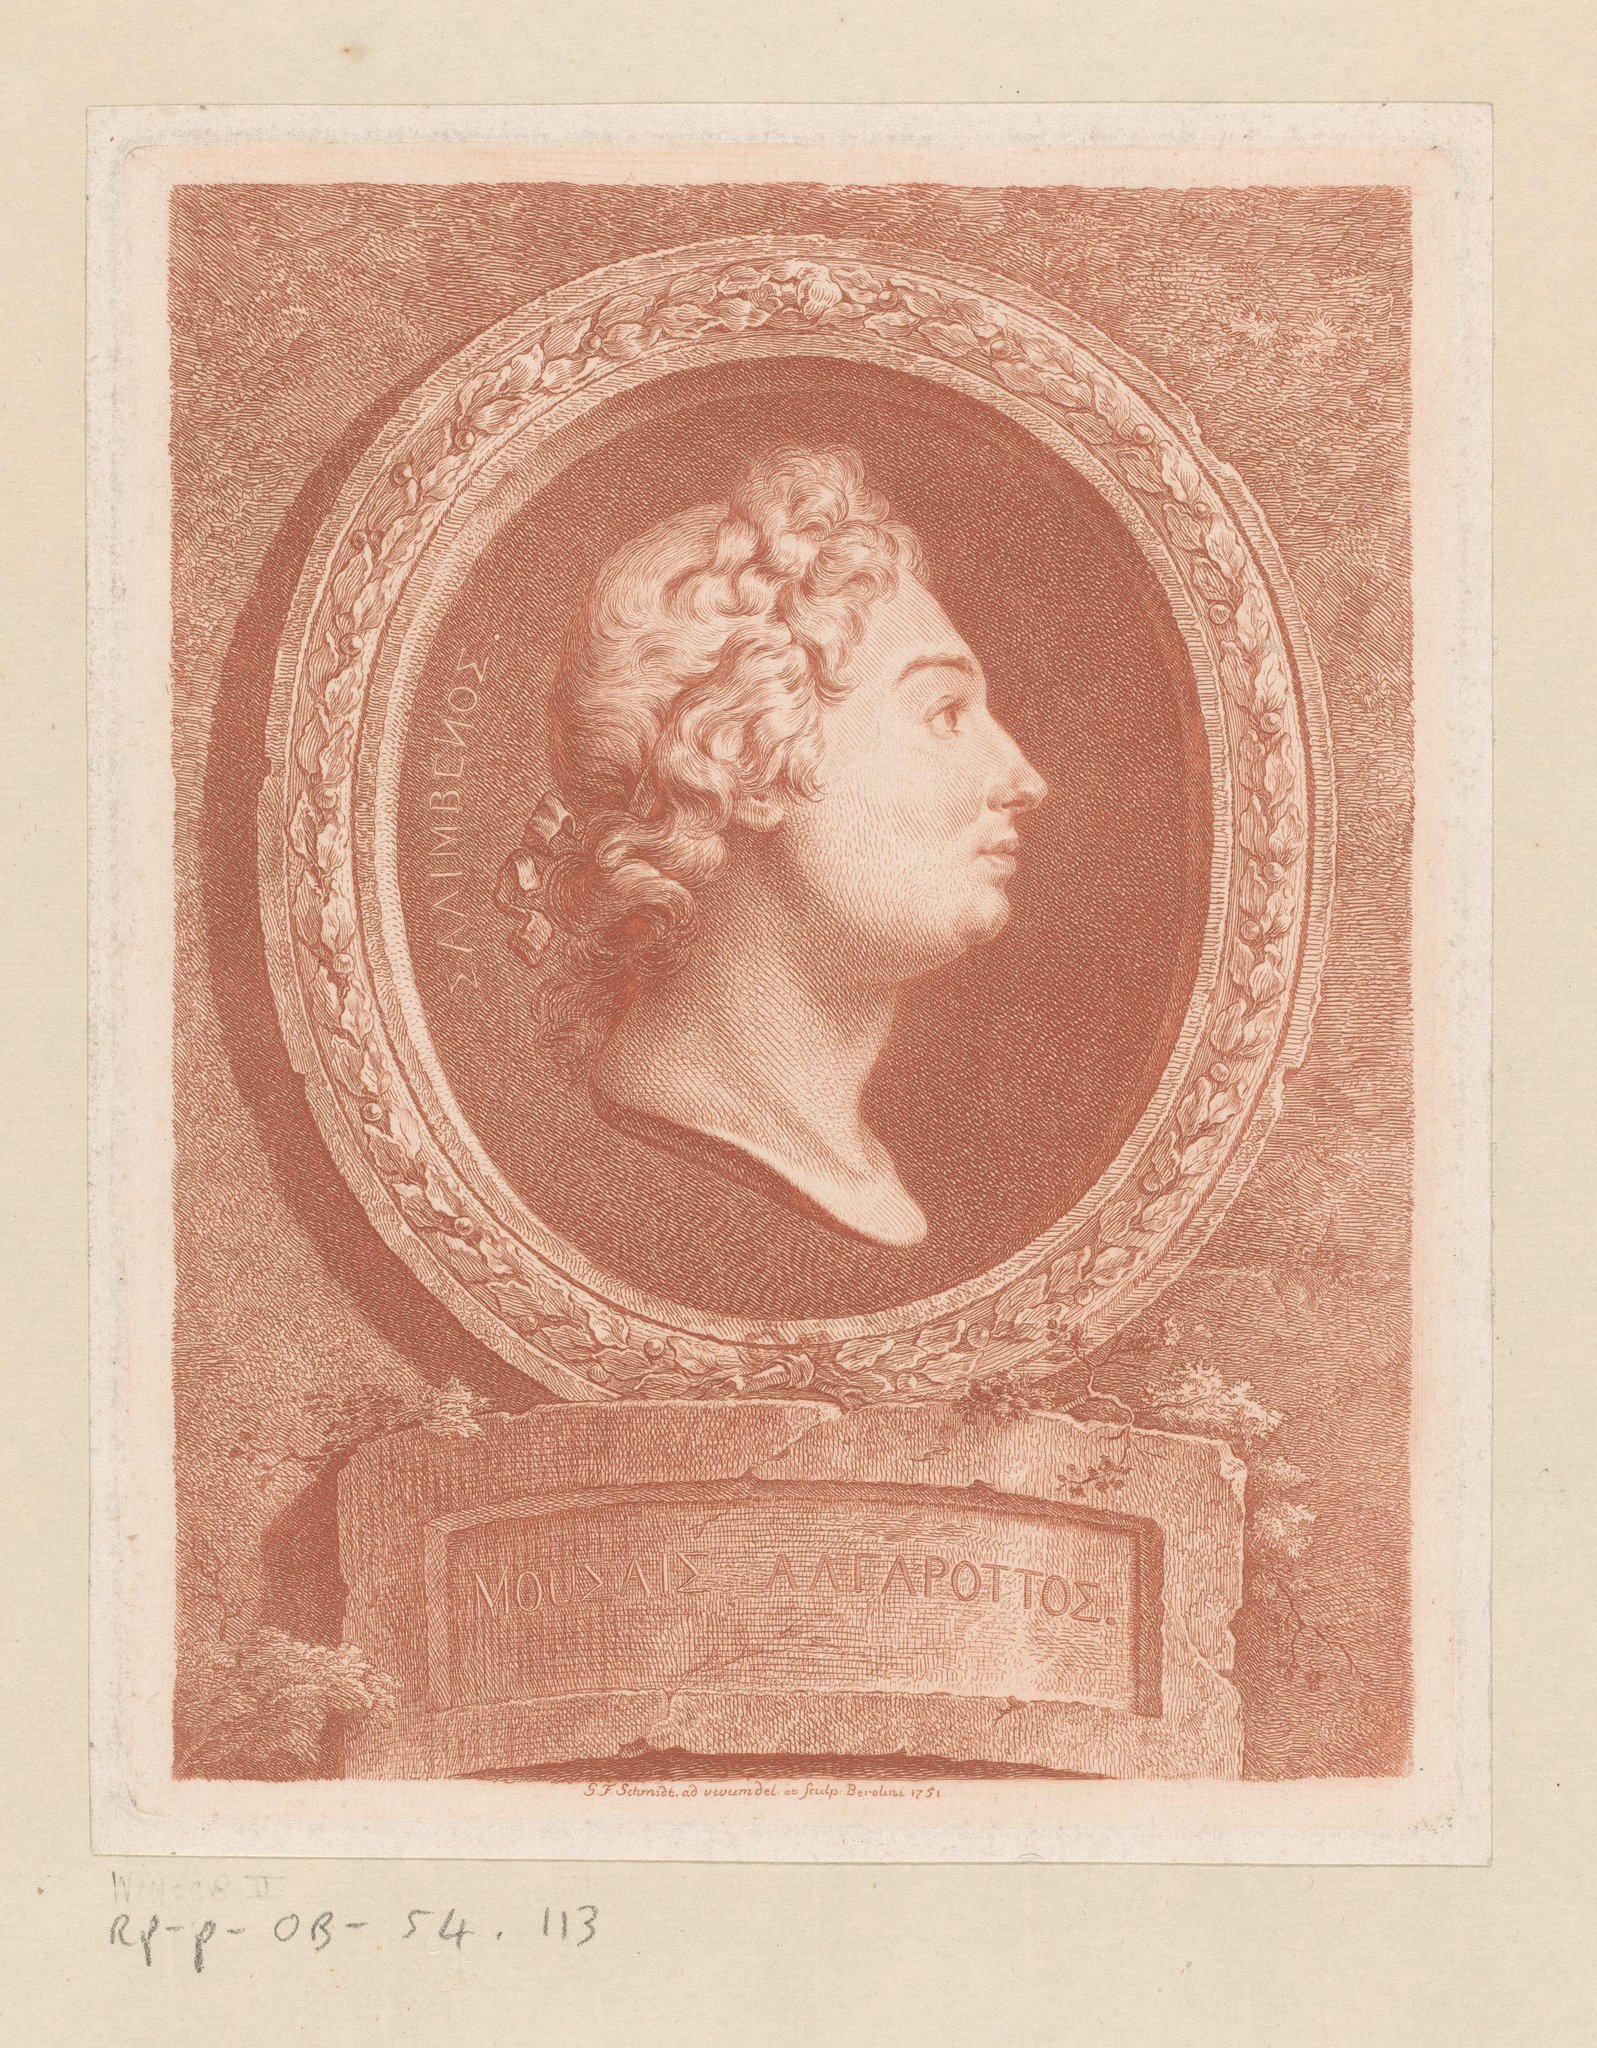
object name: print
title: Portret van Felice Salimbeni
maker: georg friedrich schmidt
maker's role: draughtsman, print maker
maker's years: 1712-1775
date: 1751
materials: paper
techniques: etching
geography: berlin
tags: historical persons - bb - woman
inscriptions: collector's mark: Lugt 240